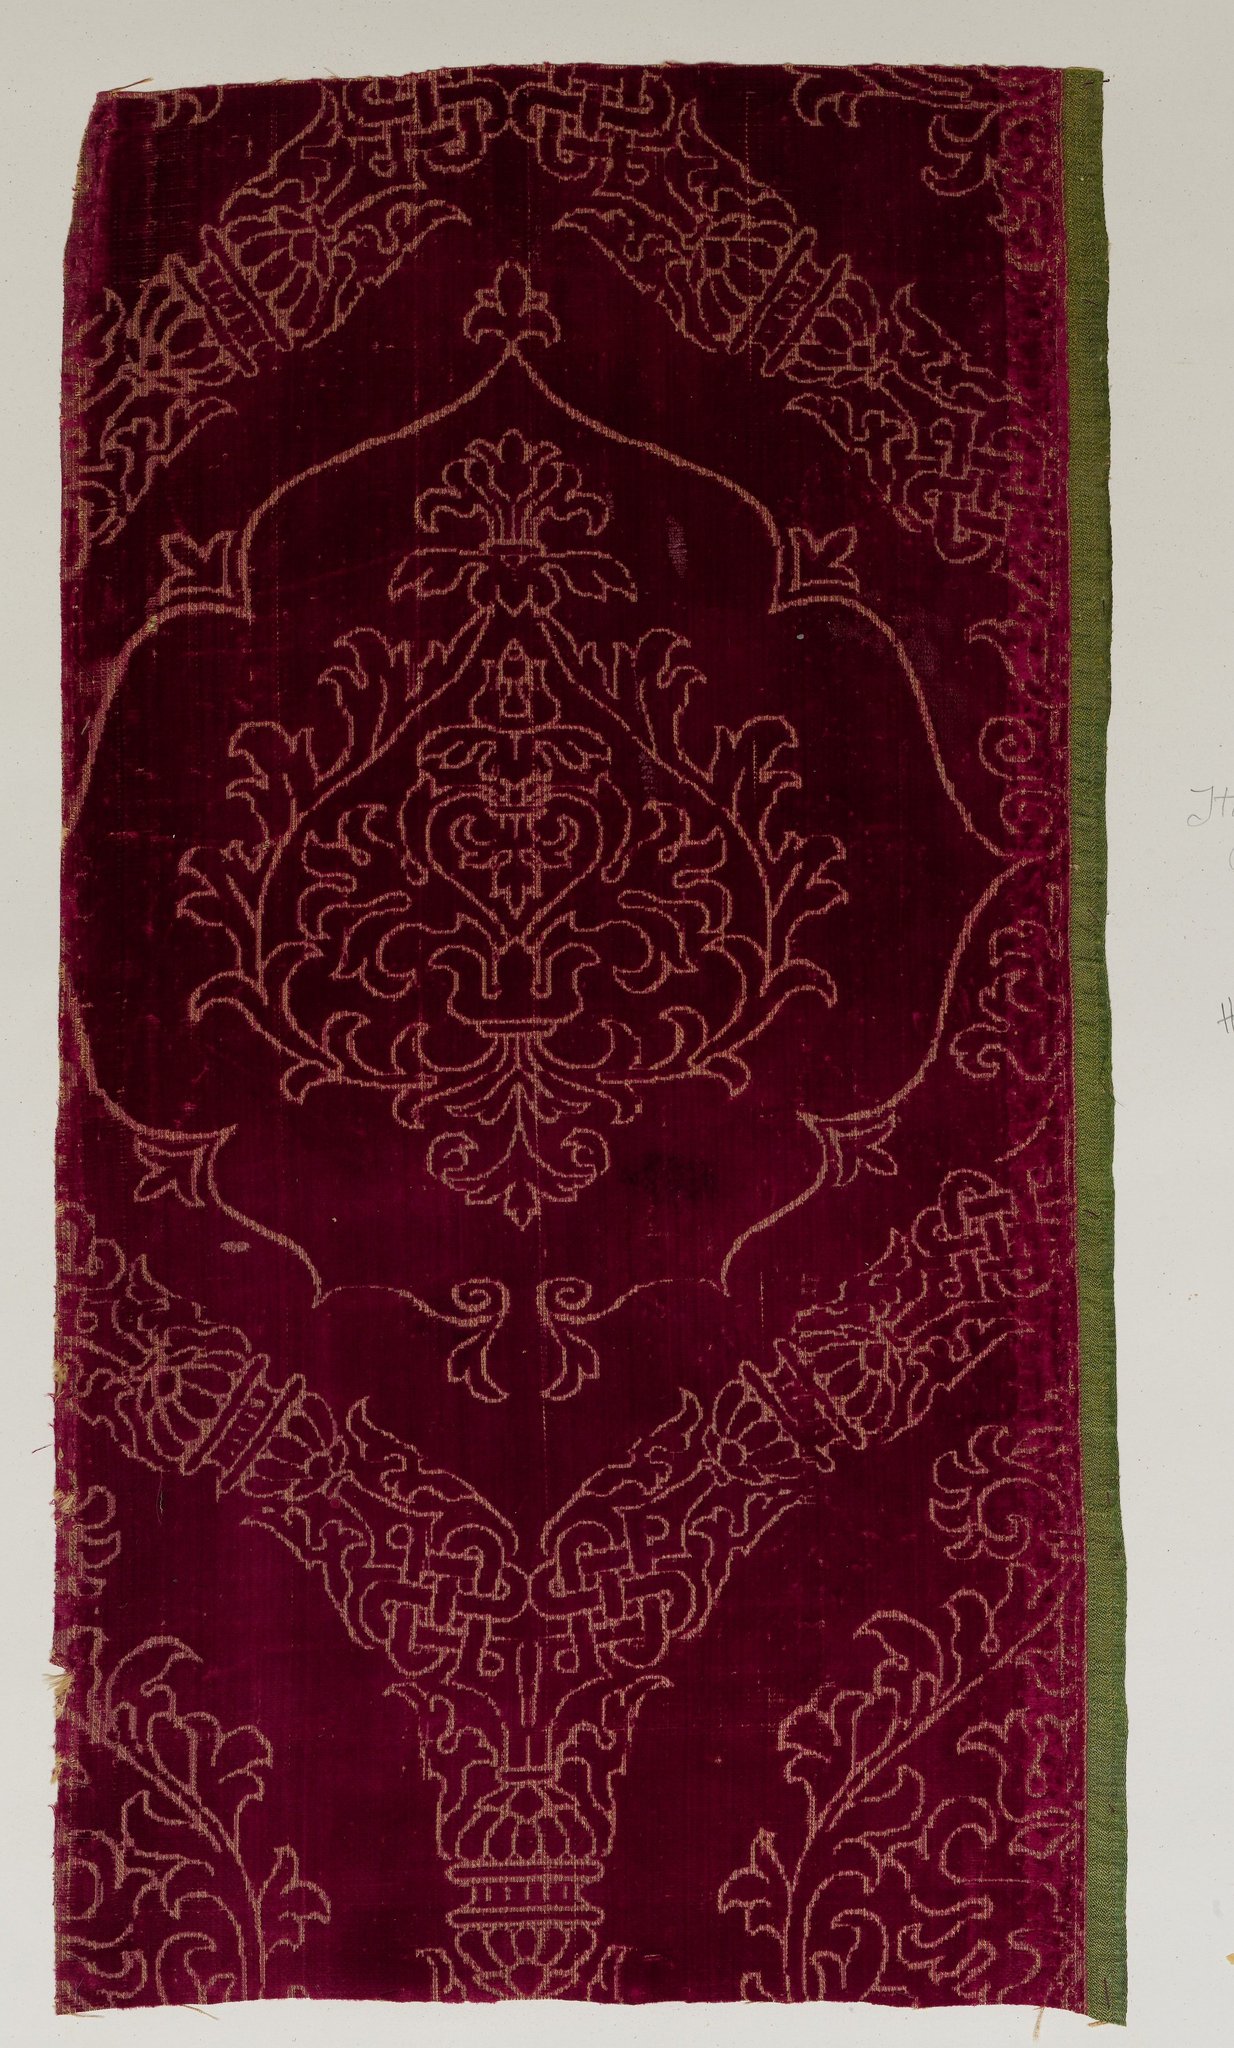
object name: fragment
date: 1501-1533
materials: silk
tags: leaves